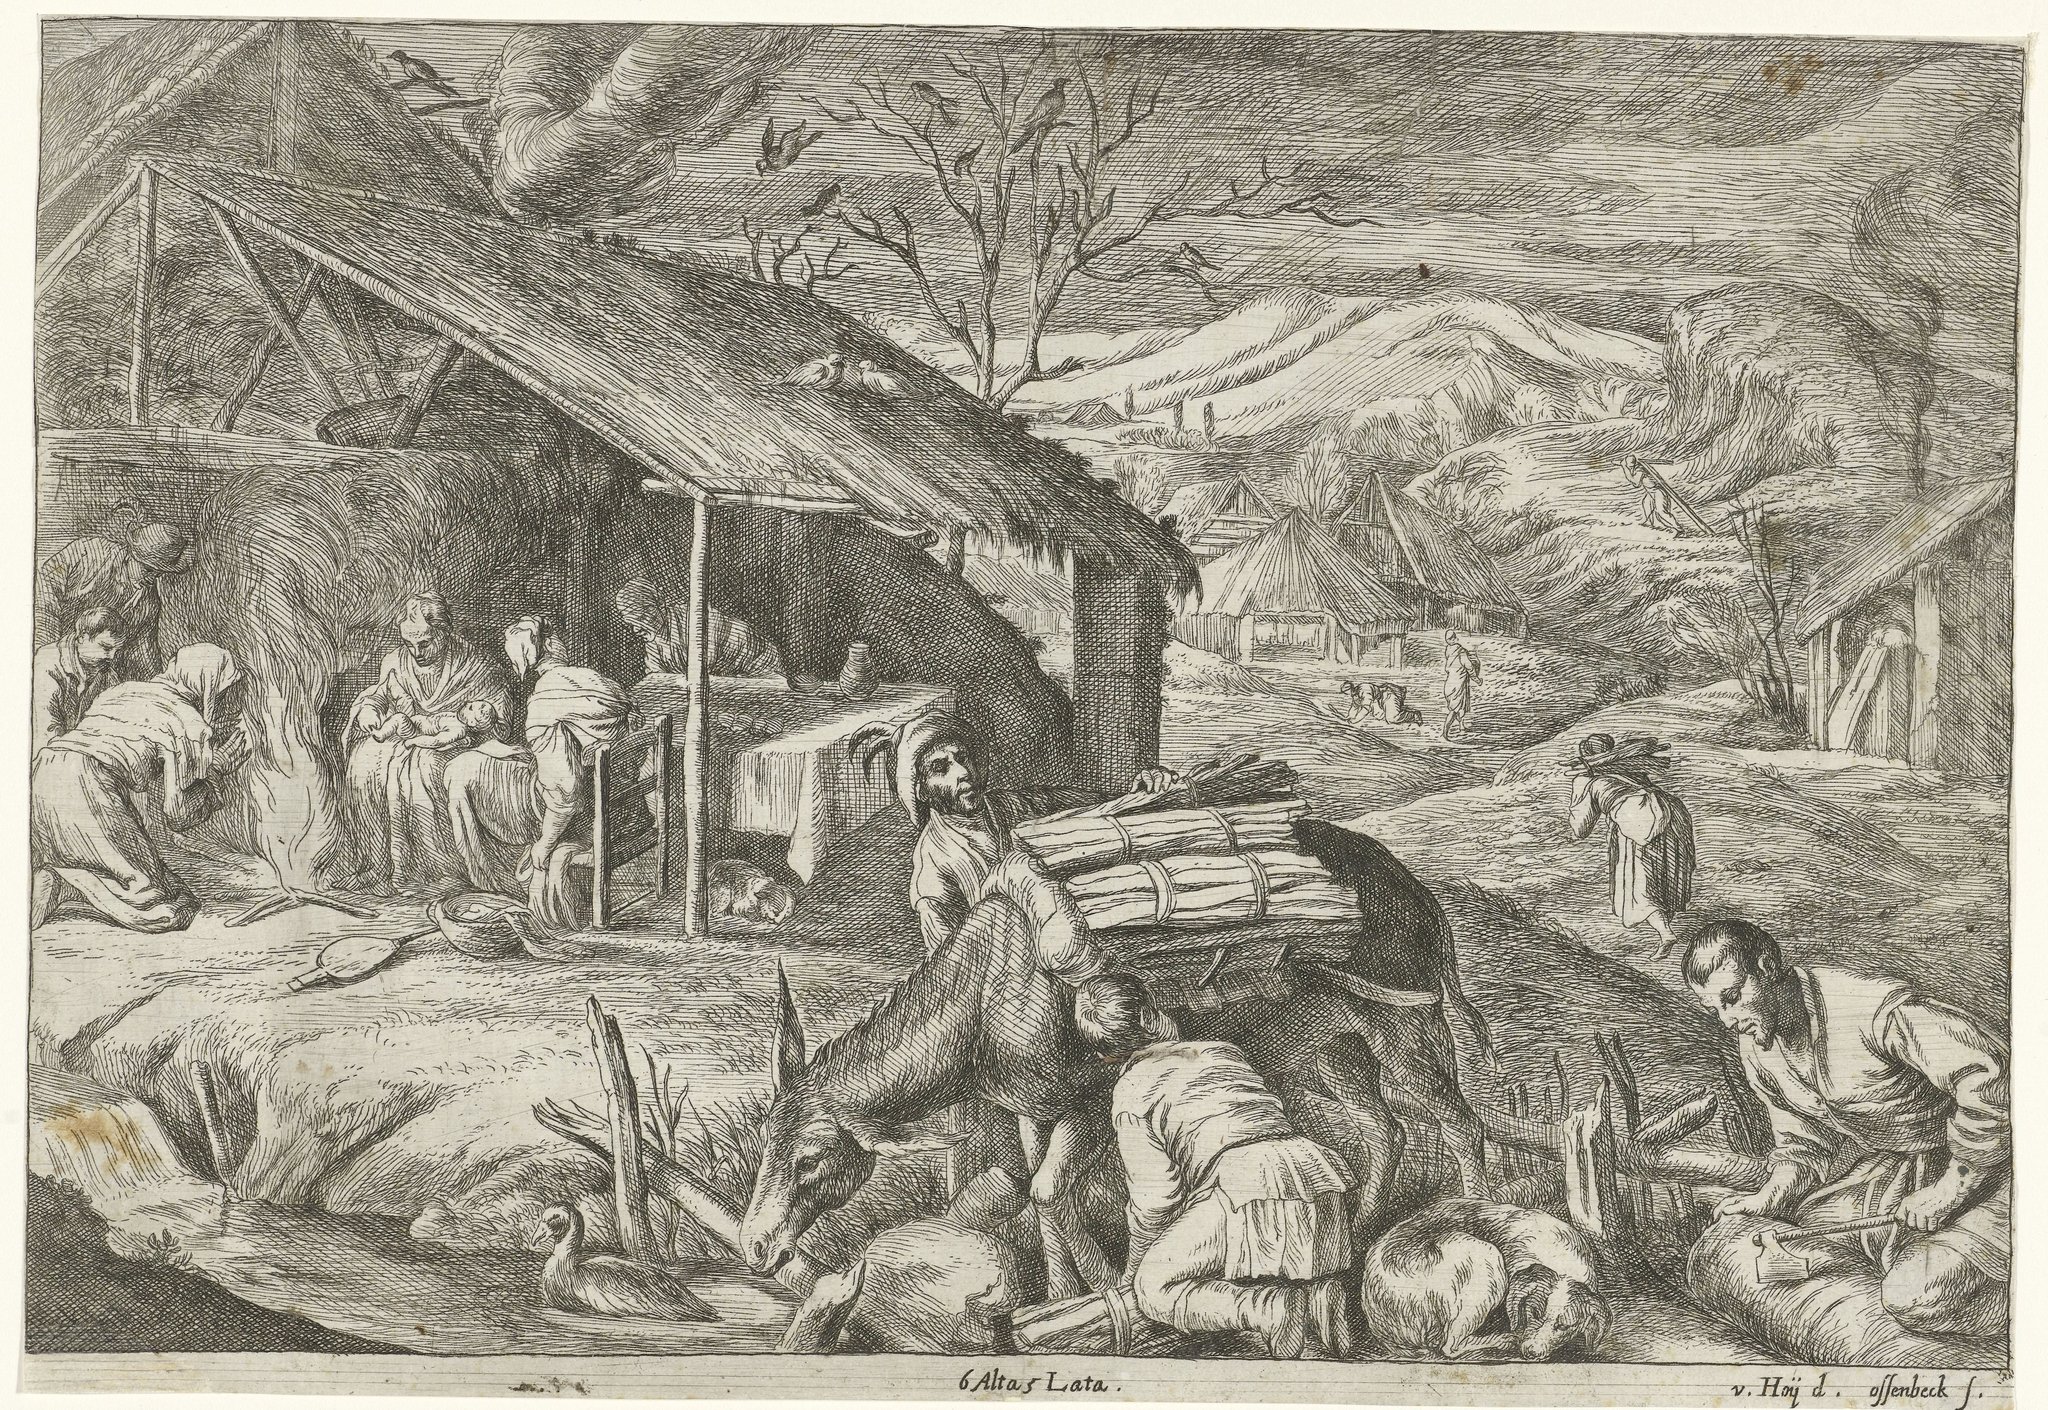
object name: print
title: De vier seizoenen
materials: paper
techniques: engraving, etching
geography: brussels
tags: woodgathering, woodgatherer, winter landscape; landscape symbolizing winter (the four seasons of the year)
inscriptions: collector's mark: Lugt 2228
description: Twee mannen beladen een ezel met hout. Een derde man hakt een boomstam in stukjes. Links een gezin dat rond een vuur zit in hun hut en schuilt voor de winterkou. Rechts drie figuren die hout sprokkelen. Voorstelling van de winter uit een prentserie van de vier seizoenen.